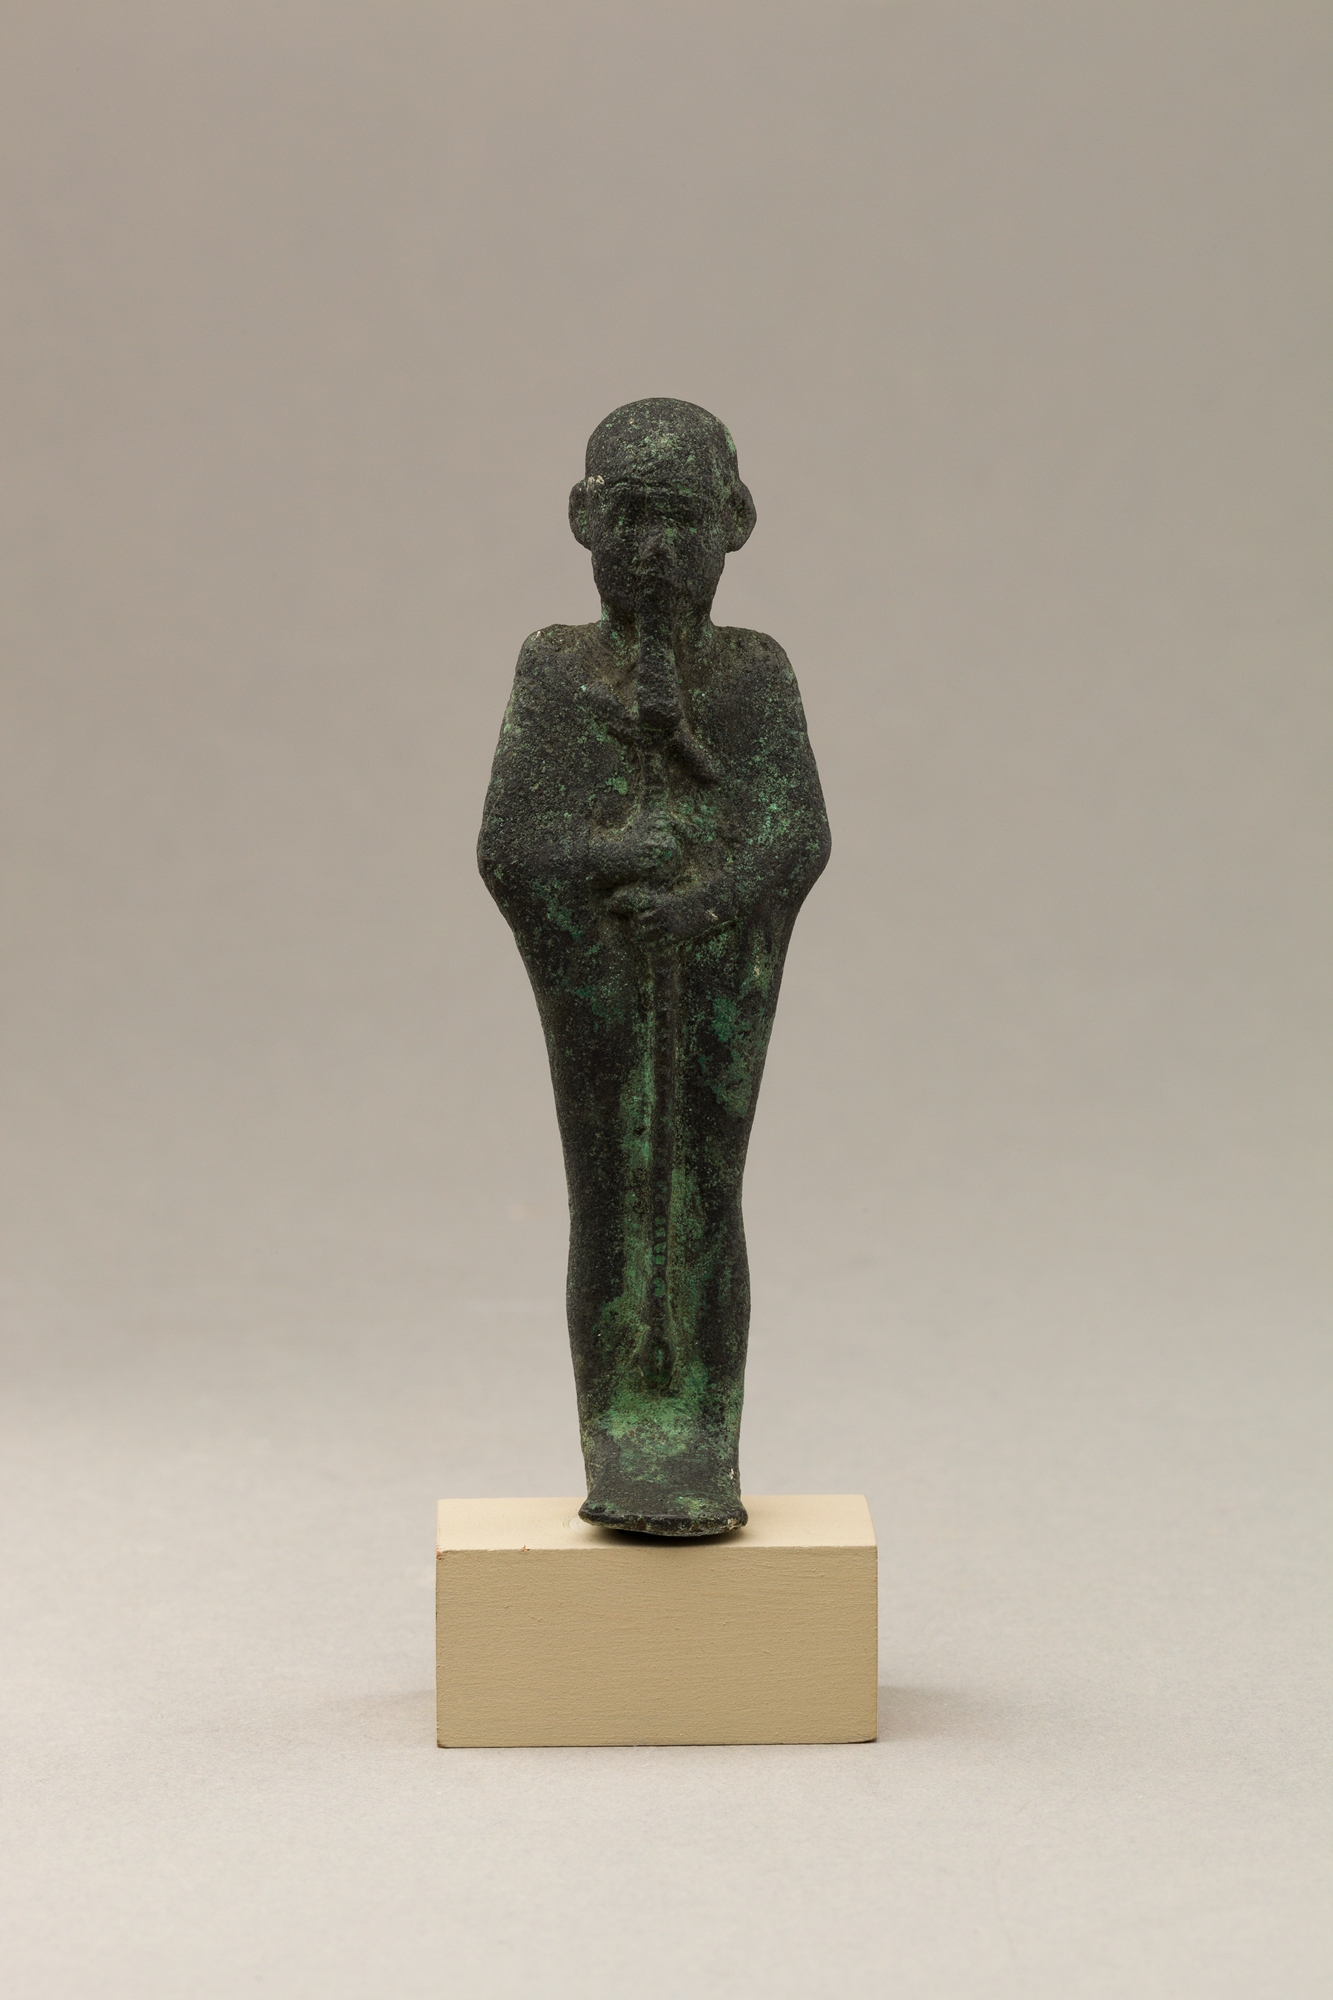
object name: statuette, ptah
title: Ptah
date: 664-630 BCE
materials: metal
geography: egypt